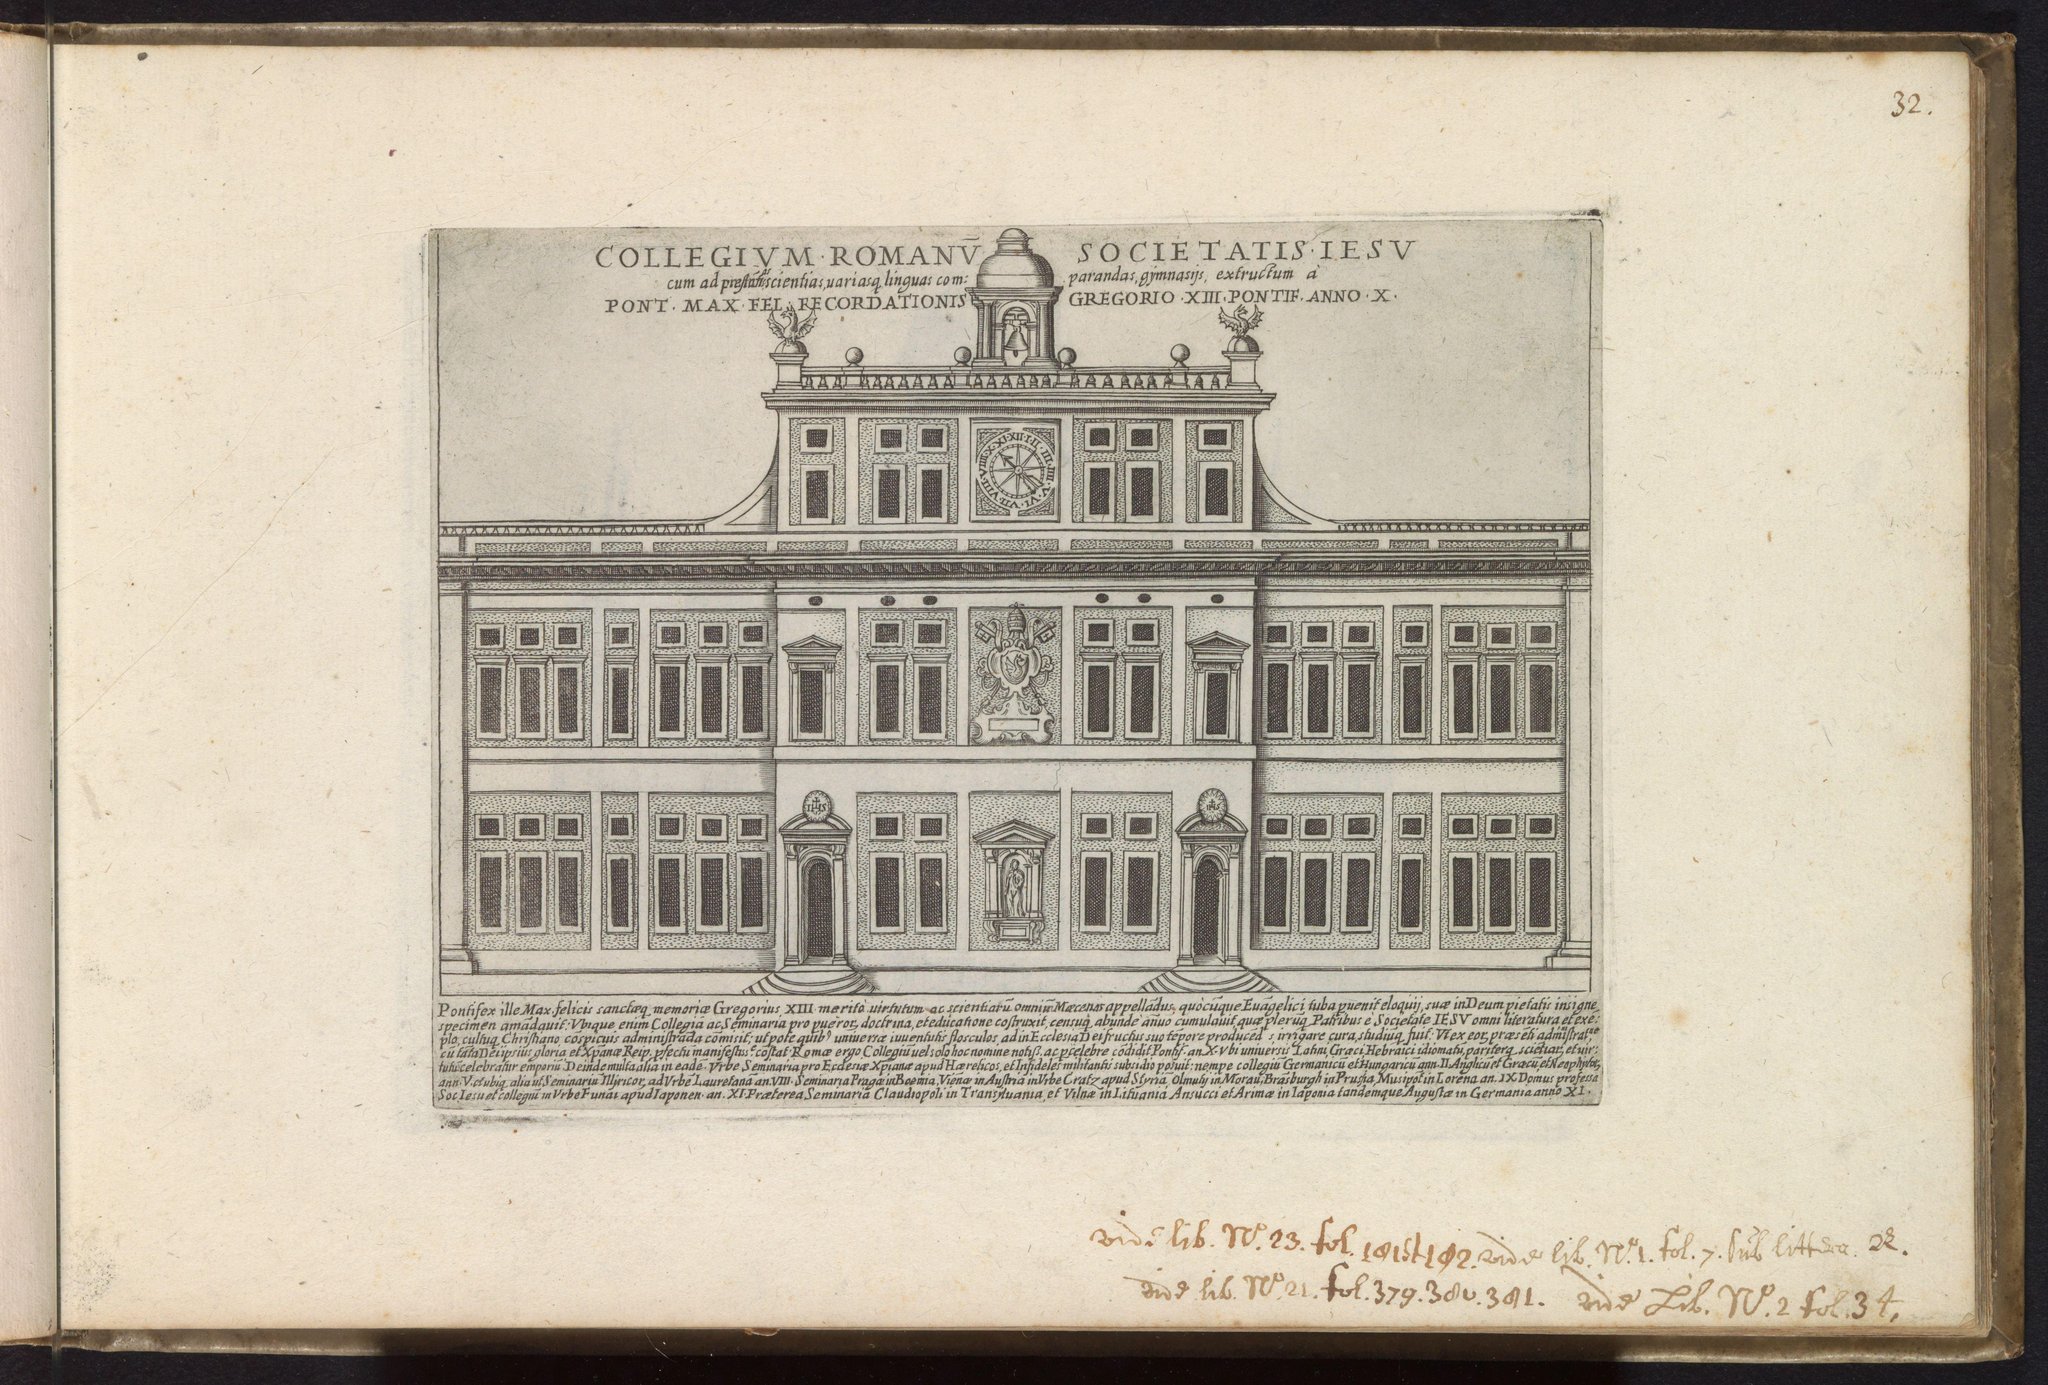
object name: print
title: Collegium Romanu societatis Iesu (...)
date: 1638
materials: paper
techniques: etching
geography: vatican city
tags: rome, gregorius xiii, university building, college, façade (of house or building)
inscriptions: number: ‘32’, inscription: ‘Ende lib. No. 23. fol. 181 et 182. Ende lib. No. 1. fol. 7...’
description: Prent maakt deel uit van een reeks prenten (+ titelprent) van beroemde gebouwen in Rome en elders.